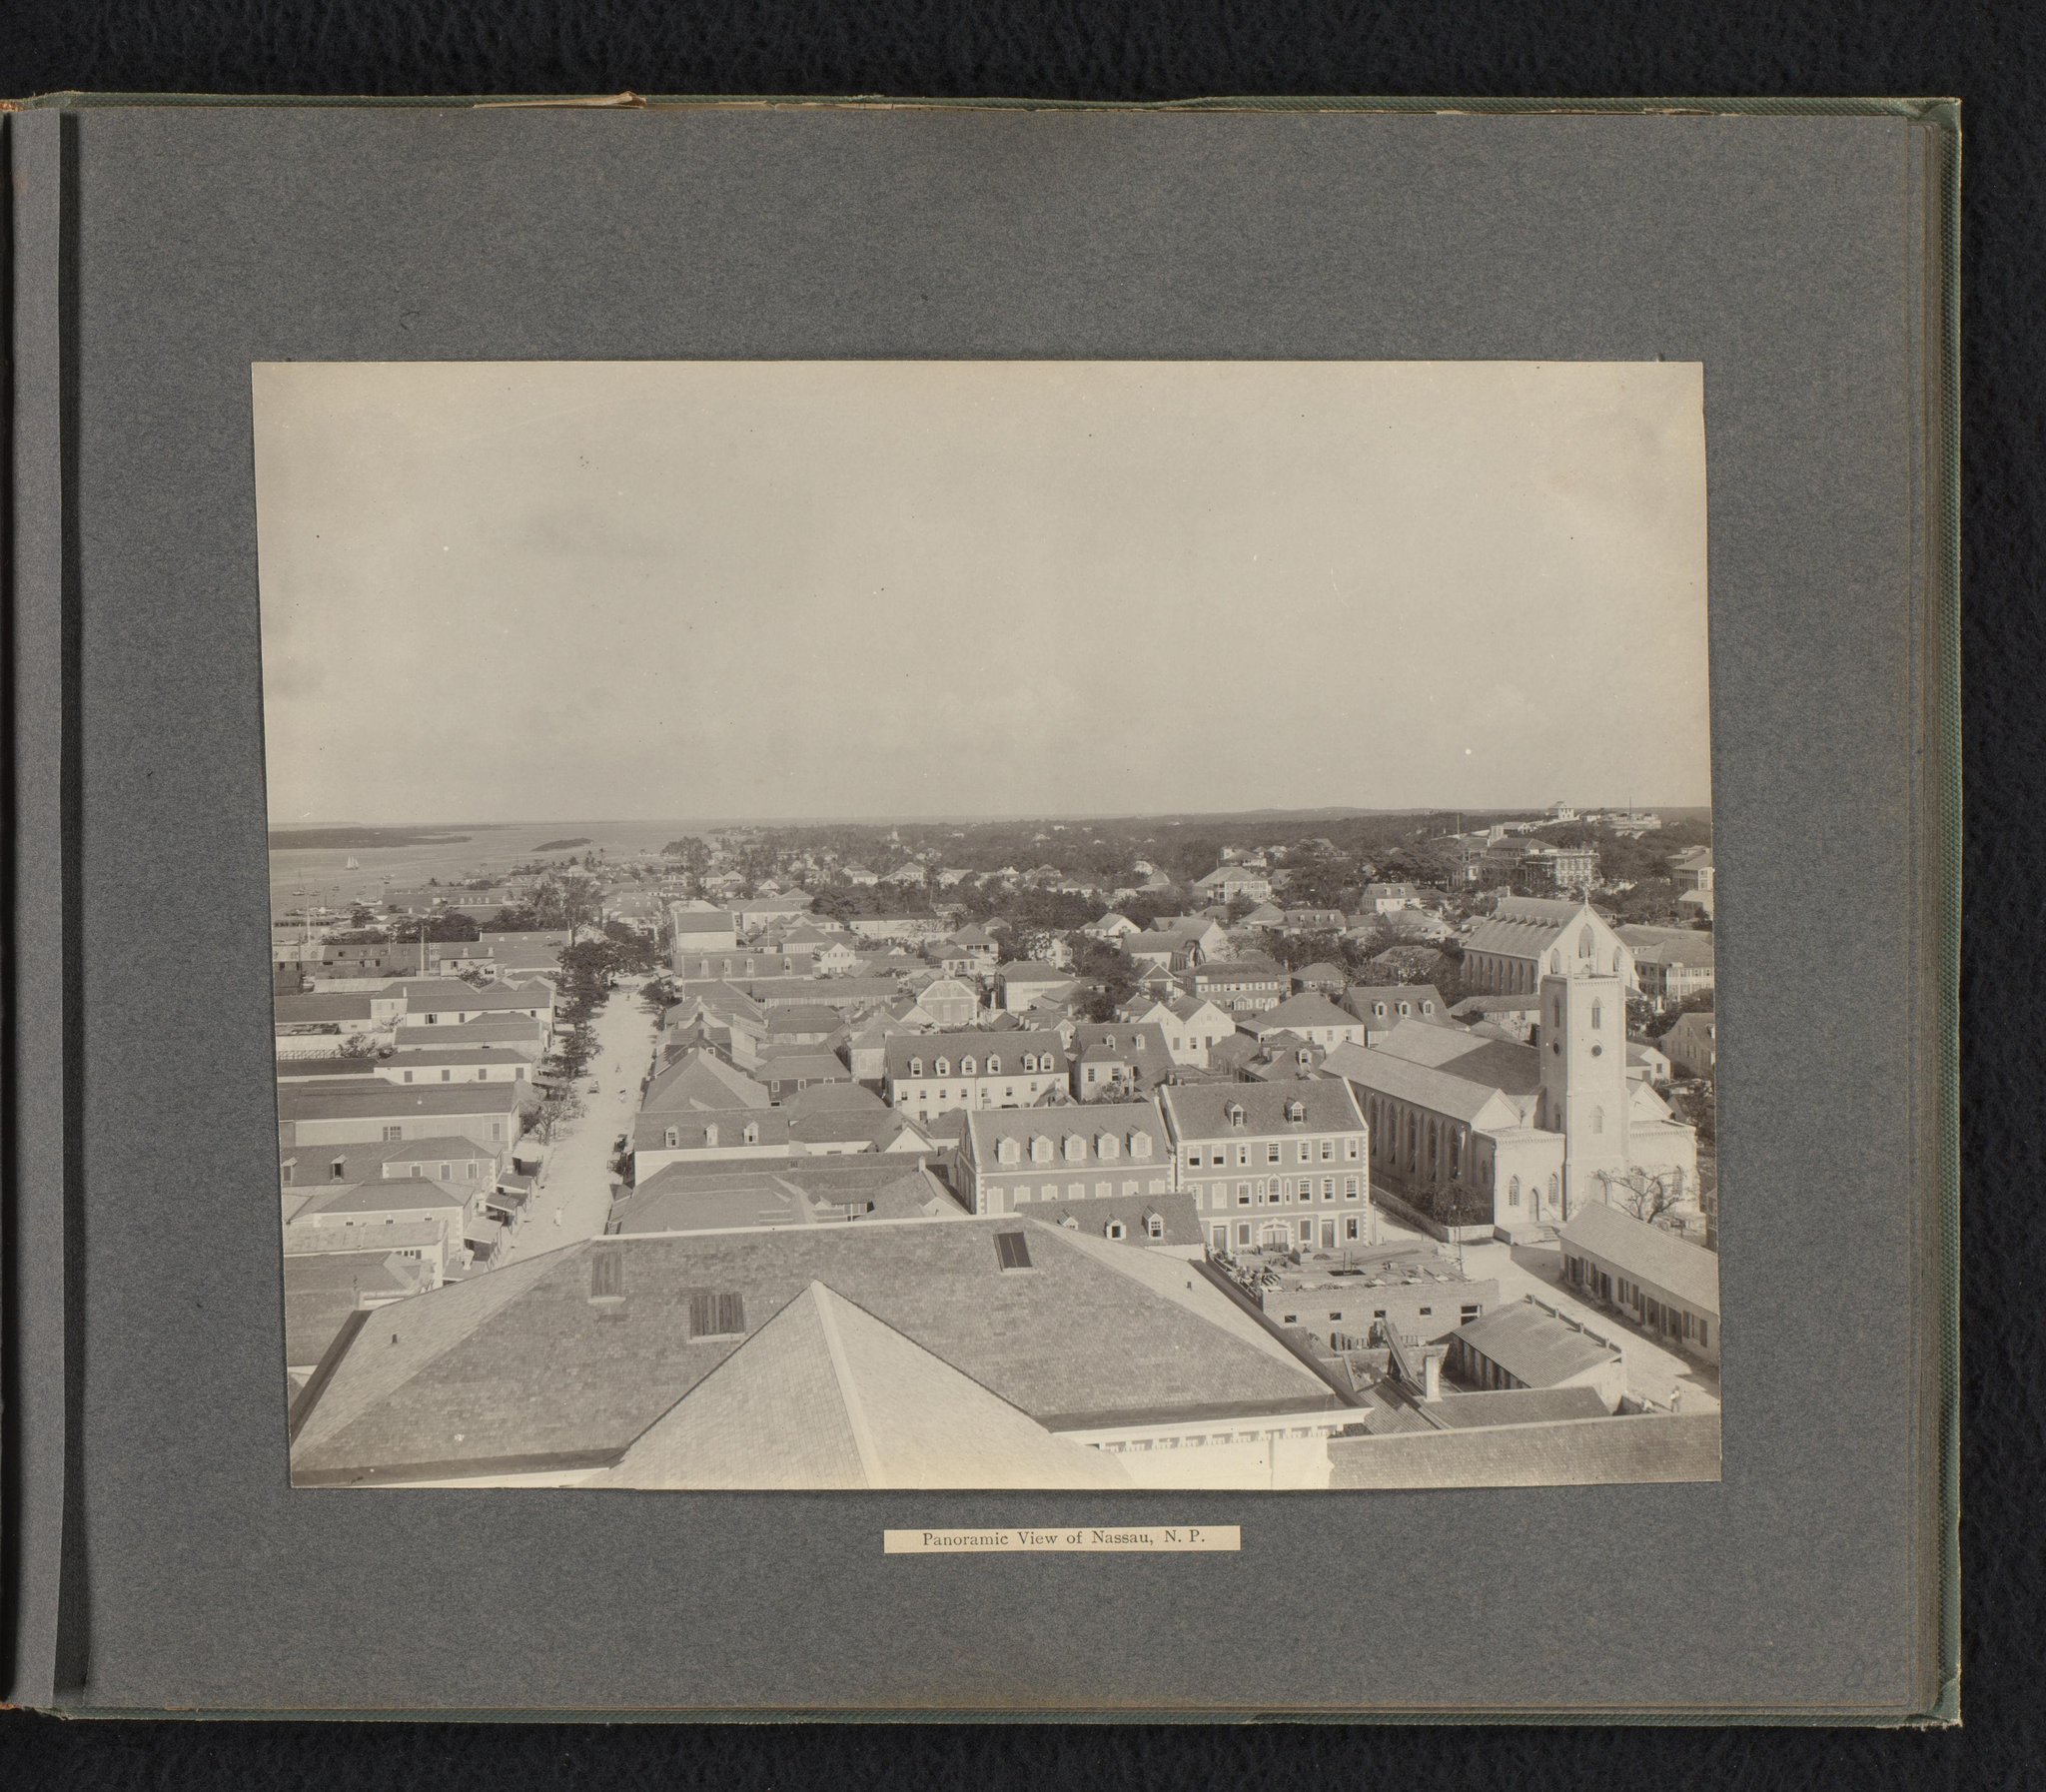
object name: photograph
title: Panoramic View of Nassau, N.P.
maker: jacob frank coonley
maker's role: fotograaf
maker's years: 1832-1915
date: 1889-1895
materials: paper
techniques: platinum process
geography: nassau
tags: city-view in general; 'veduta'